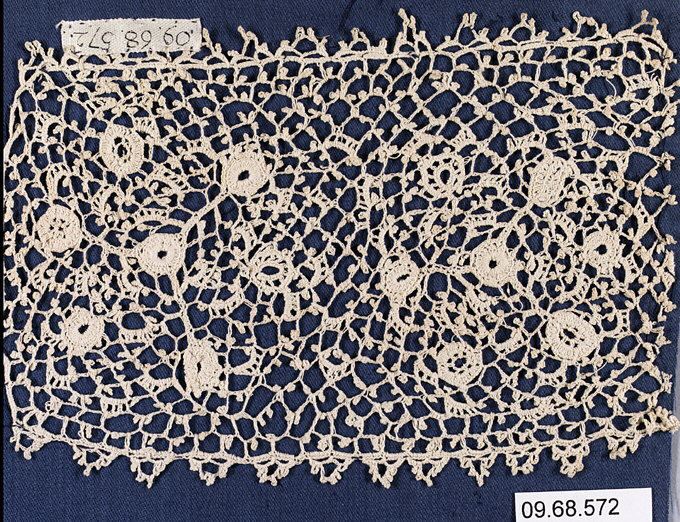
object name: specimen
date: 1801-1900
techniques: crochet